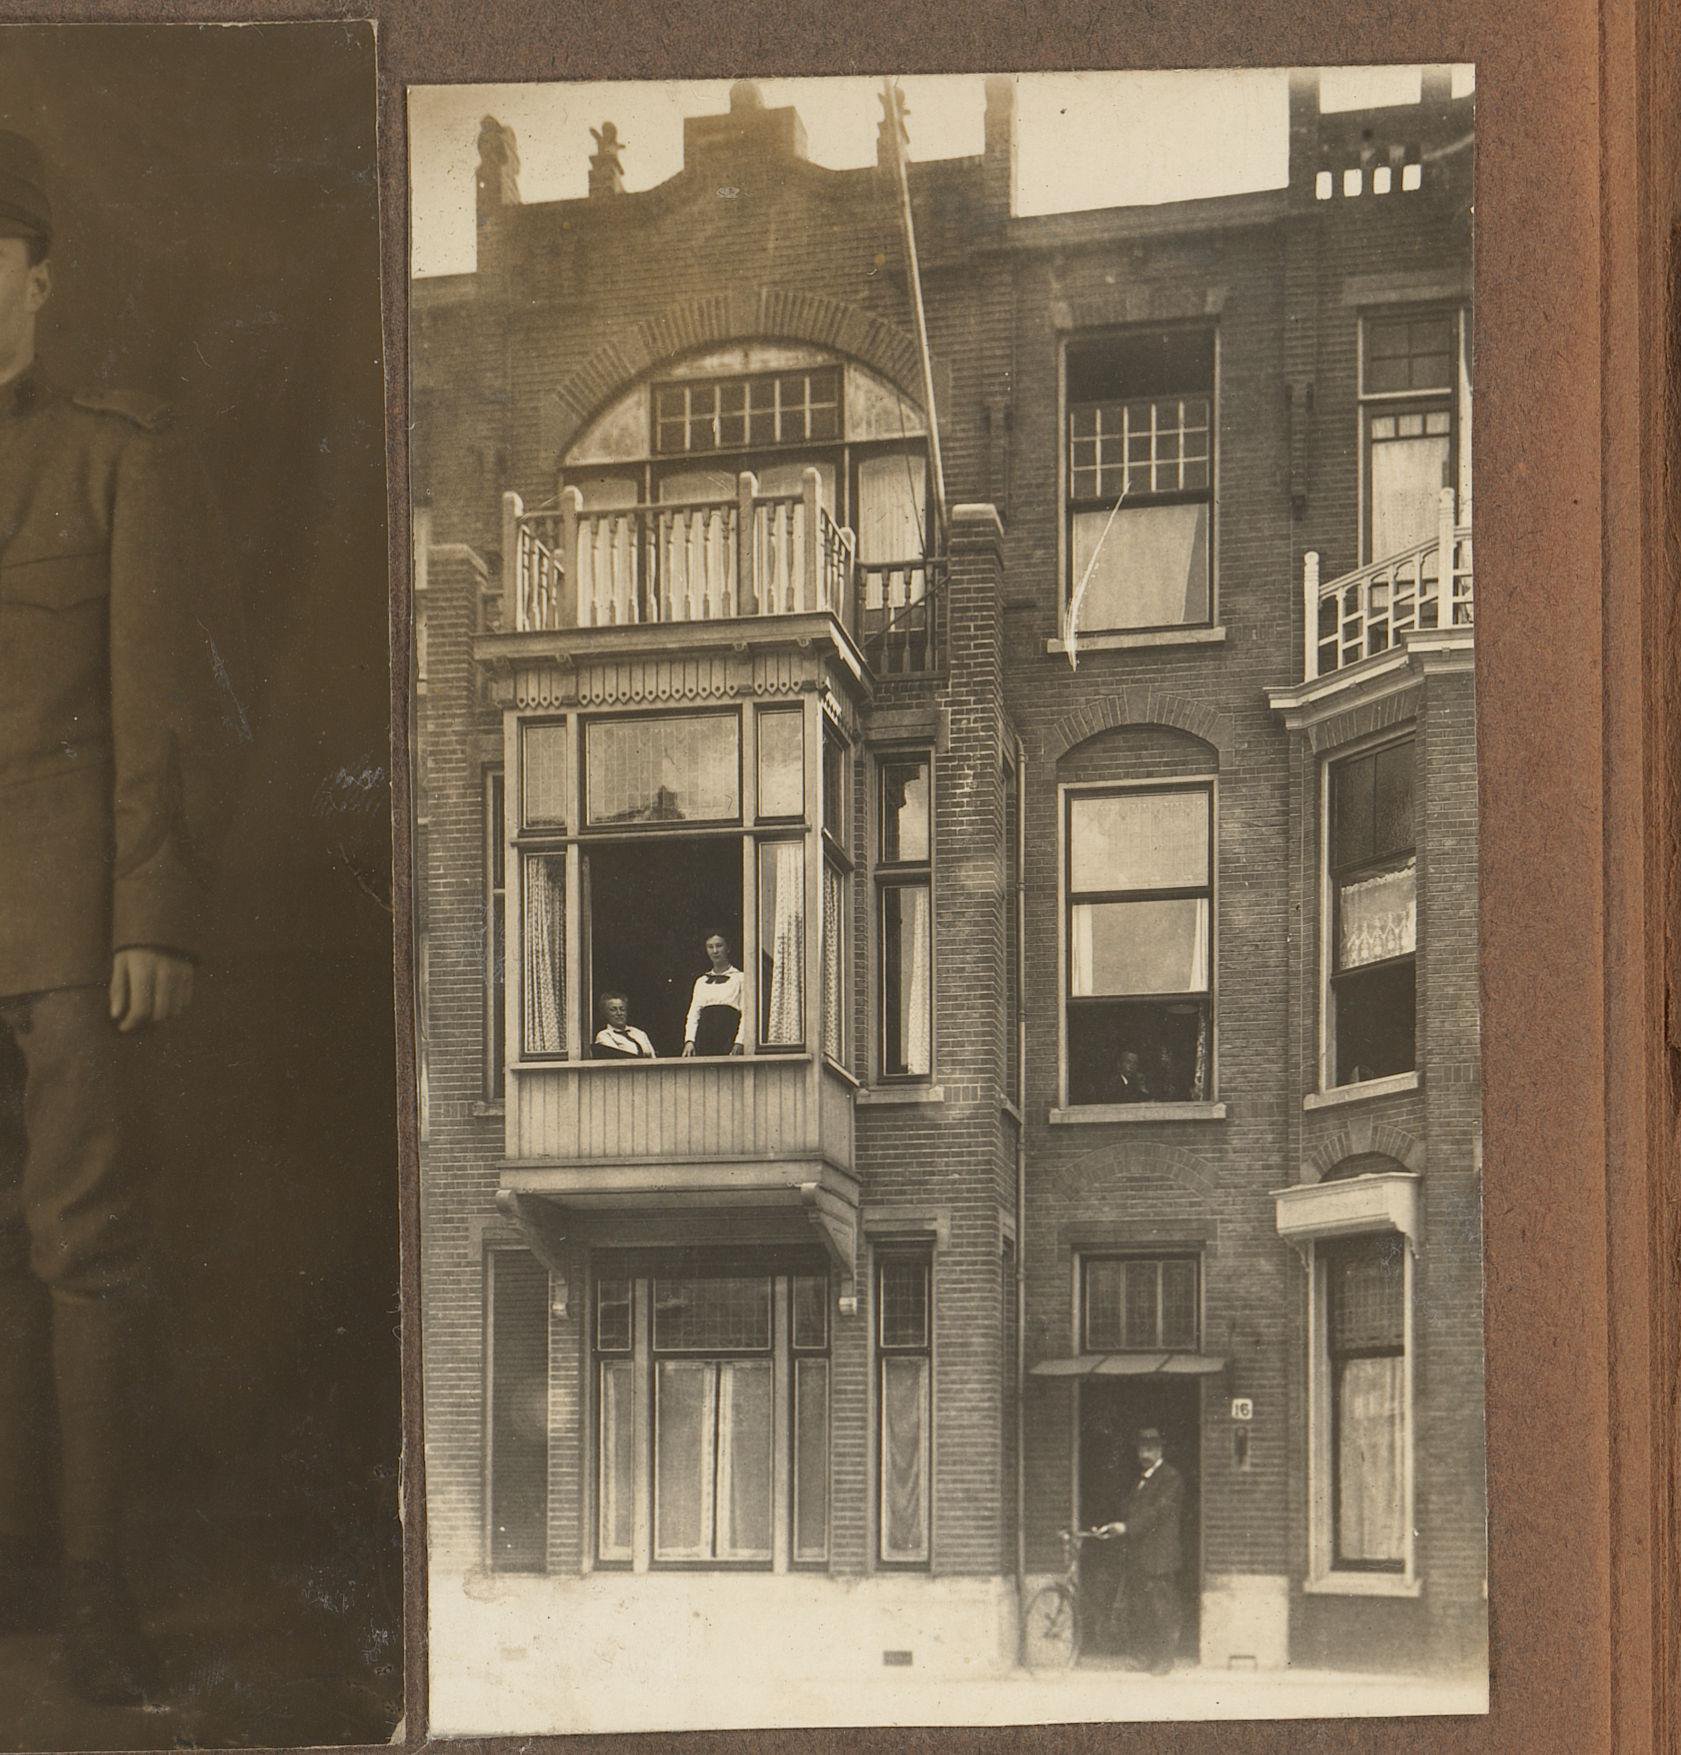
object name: photograph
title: Woning met erker waarin twee vrouwen en man met fiets in deuropening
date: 1870-1920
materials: photographic support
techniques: photography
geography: netherlands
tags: netherlands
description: Foto op bruin albumblad 39 van familiealbum van Alphons Diepenbrock.